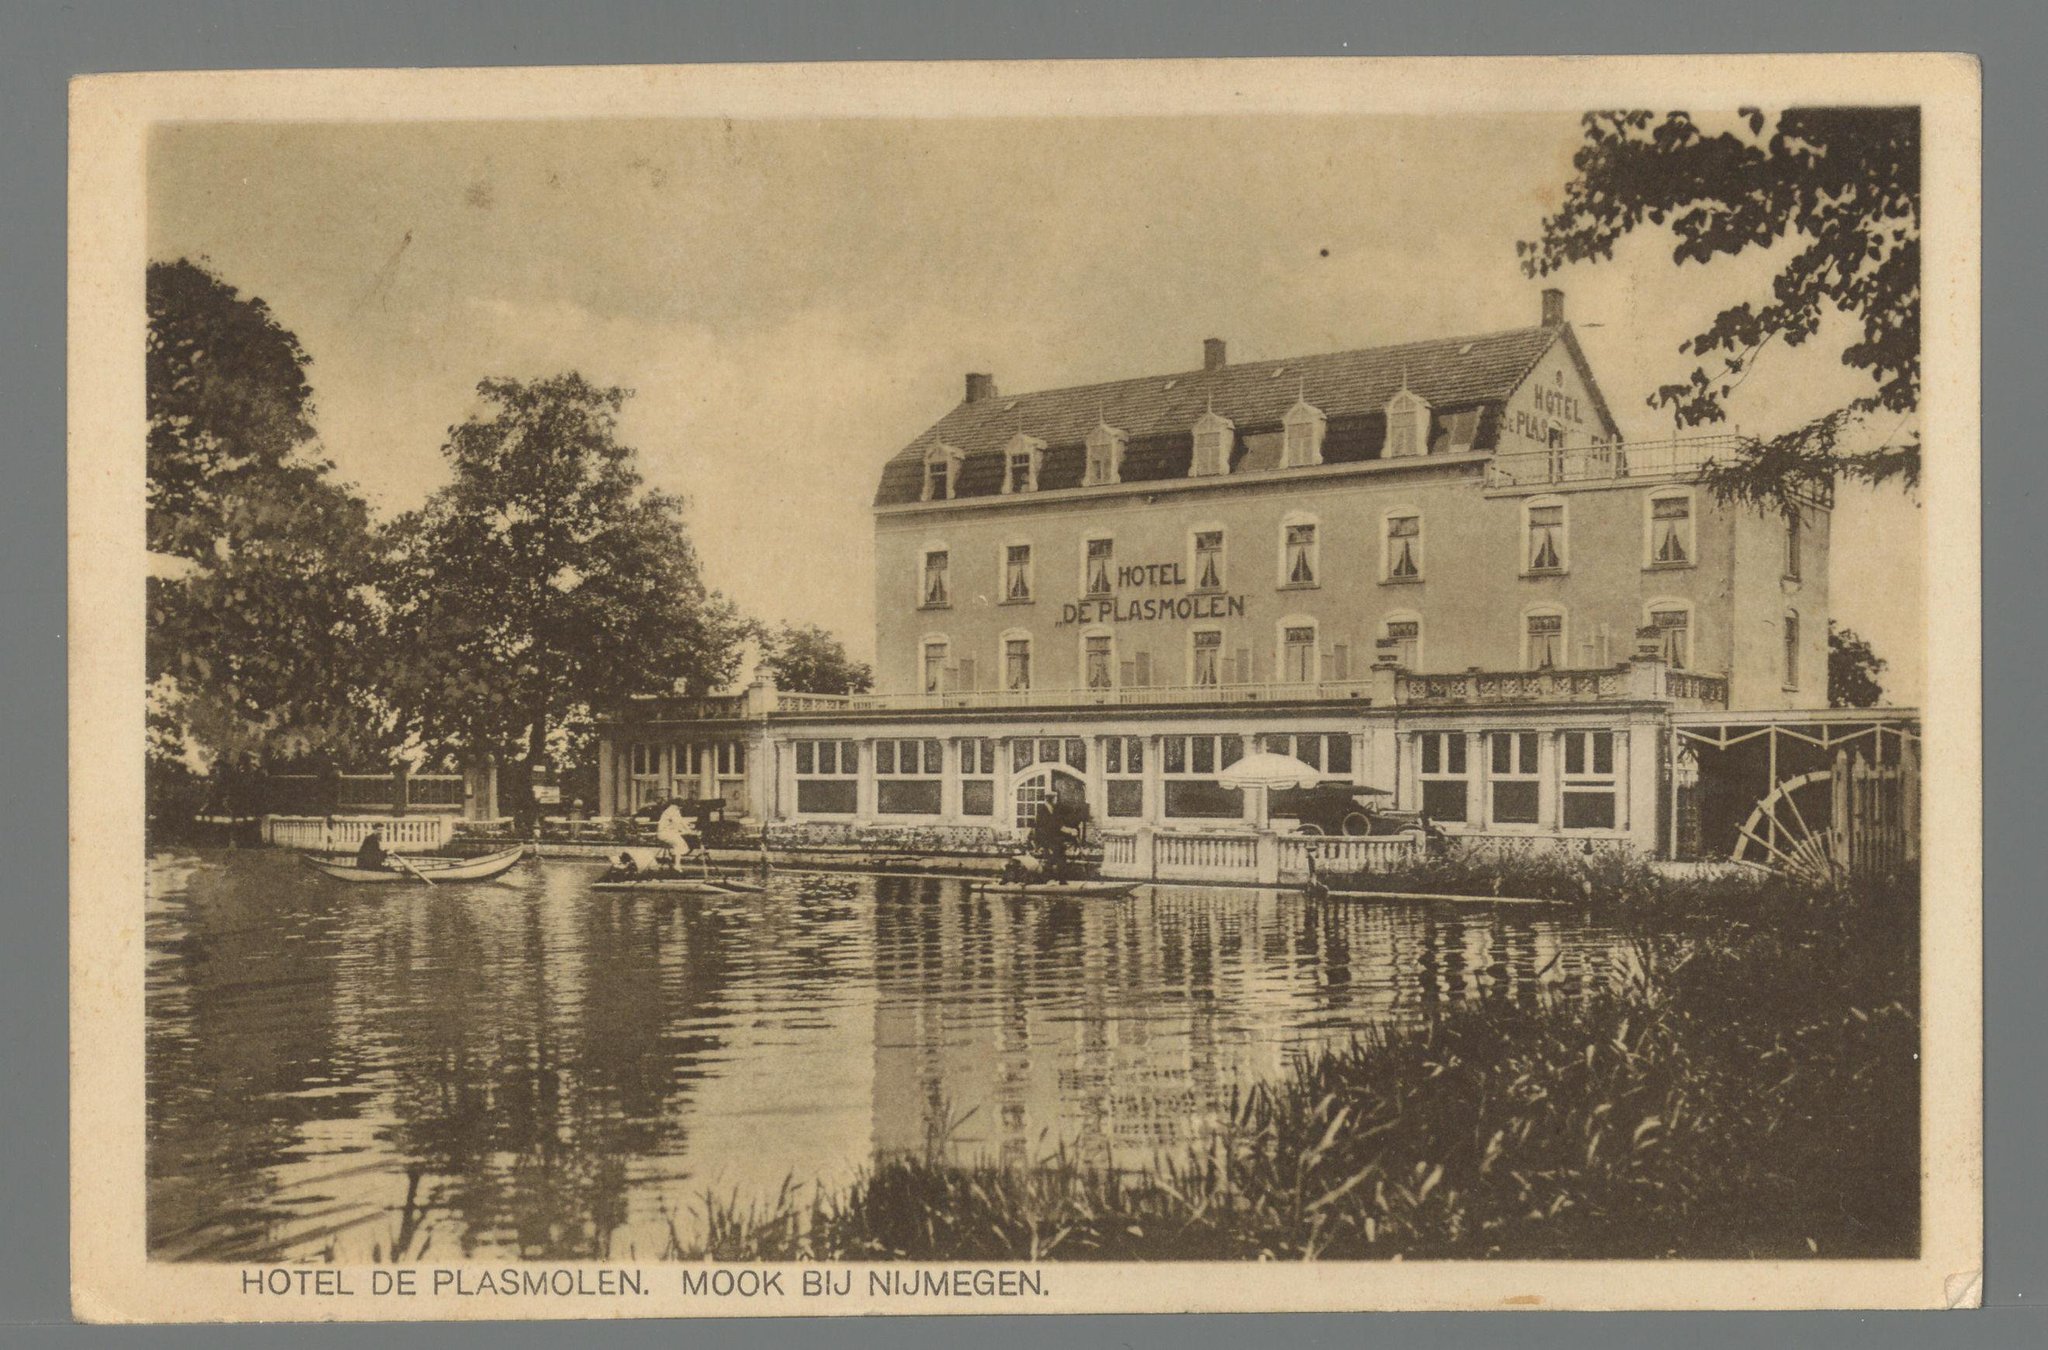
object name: ansichtkaart, prentbriefkaart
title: Hotel De Plasmolen. Mook bij Nijmegen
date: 1913-1928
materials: cardboard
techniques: photograph, writing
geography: plasmolen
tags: pond, hotel, hostelry, inn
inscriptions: postage stamp